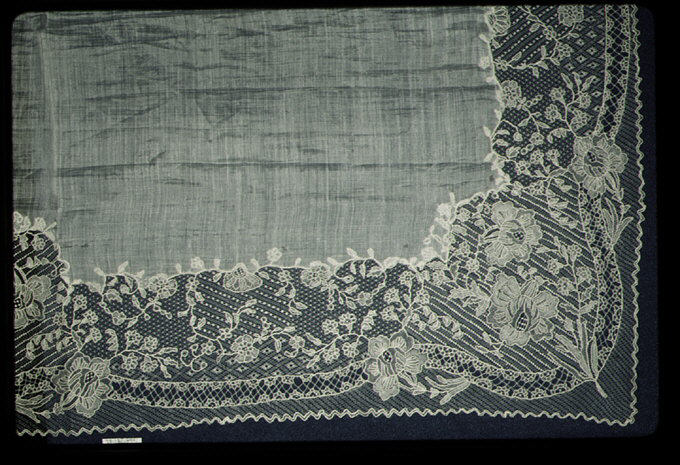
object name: handkerchief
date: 1851-1875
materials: linen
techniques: lace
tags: flowers